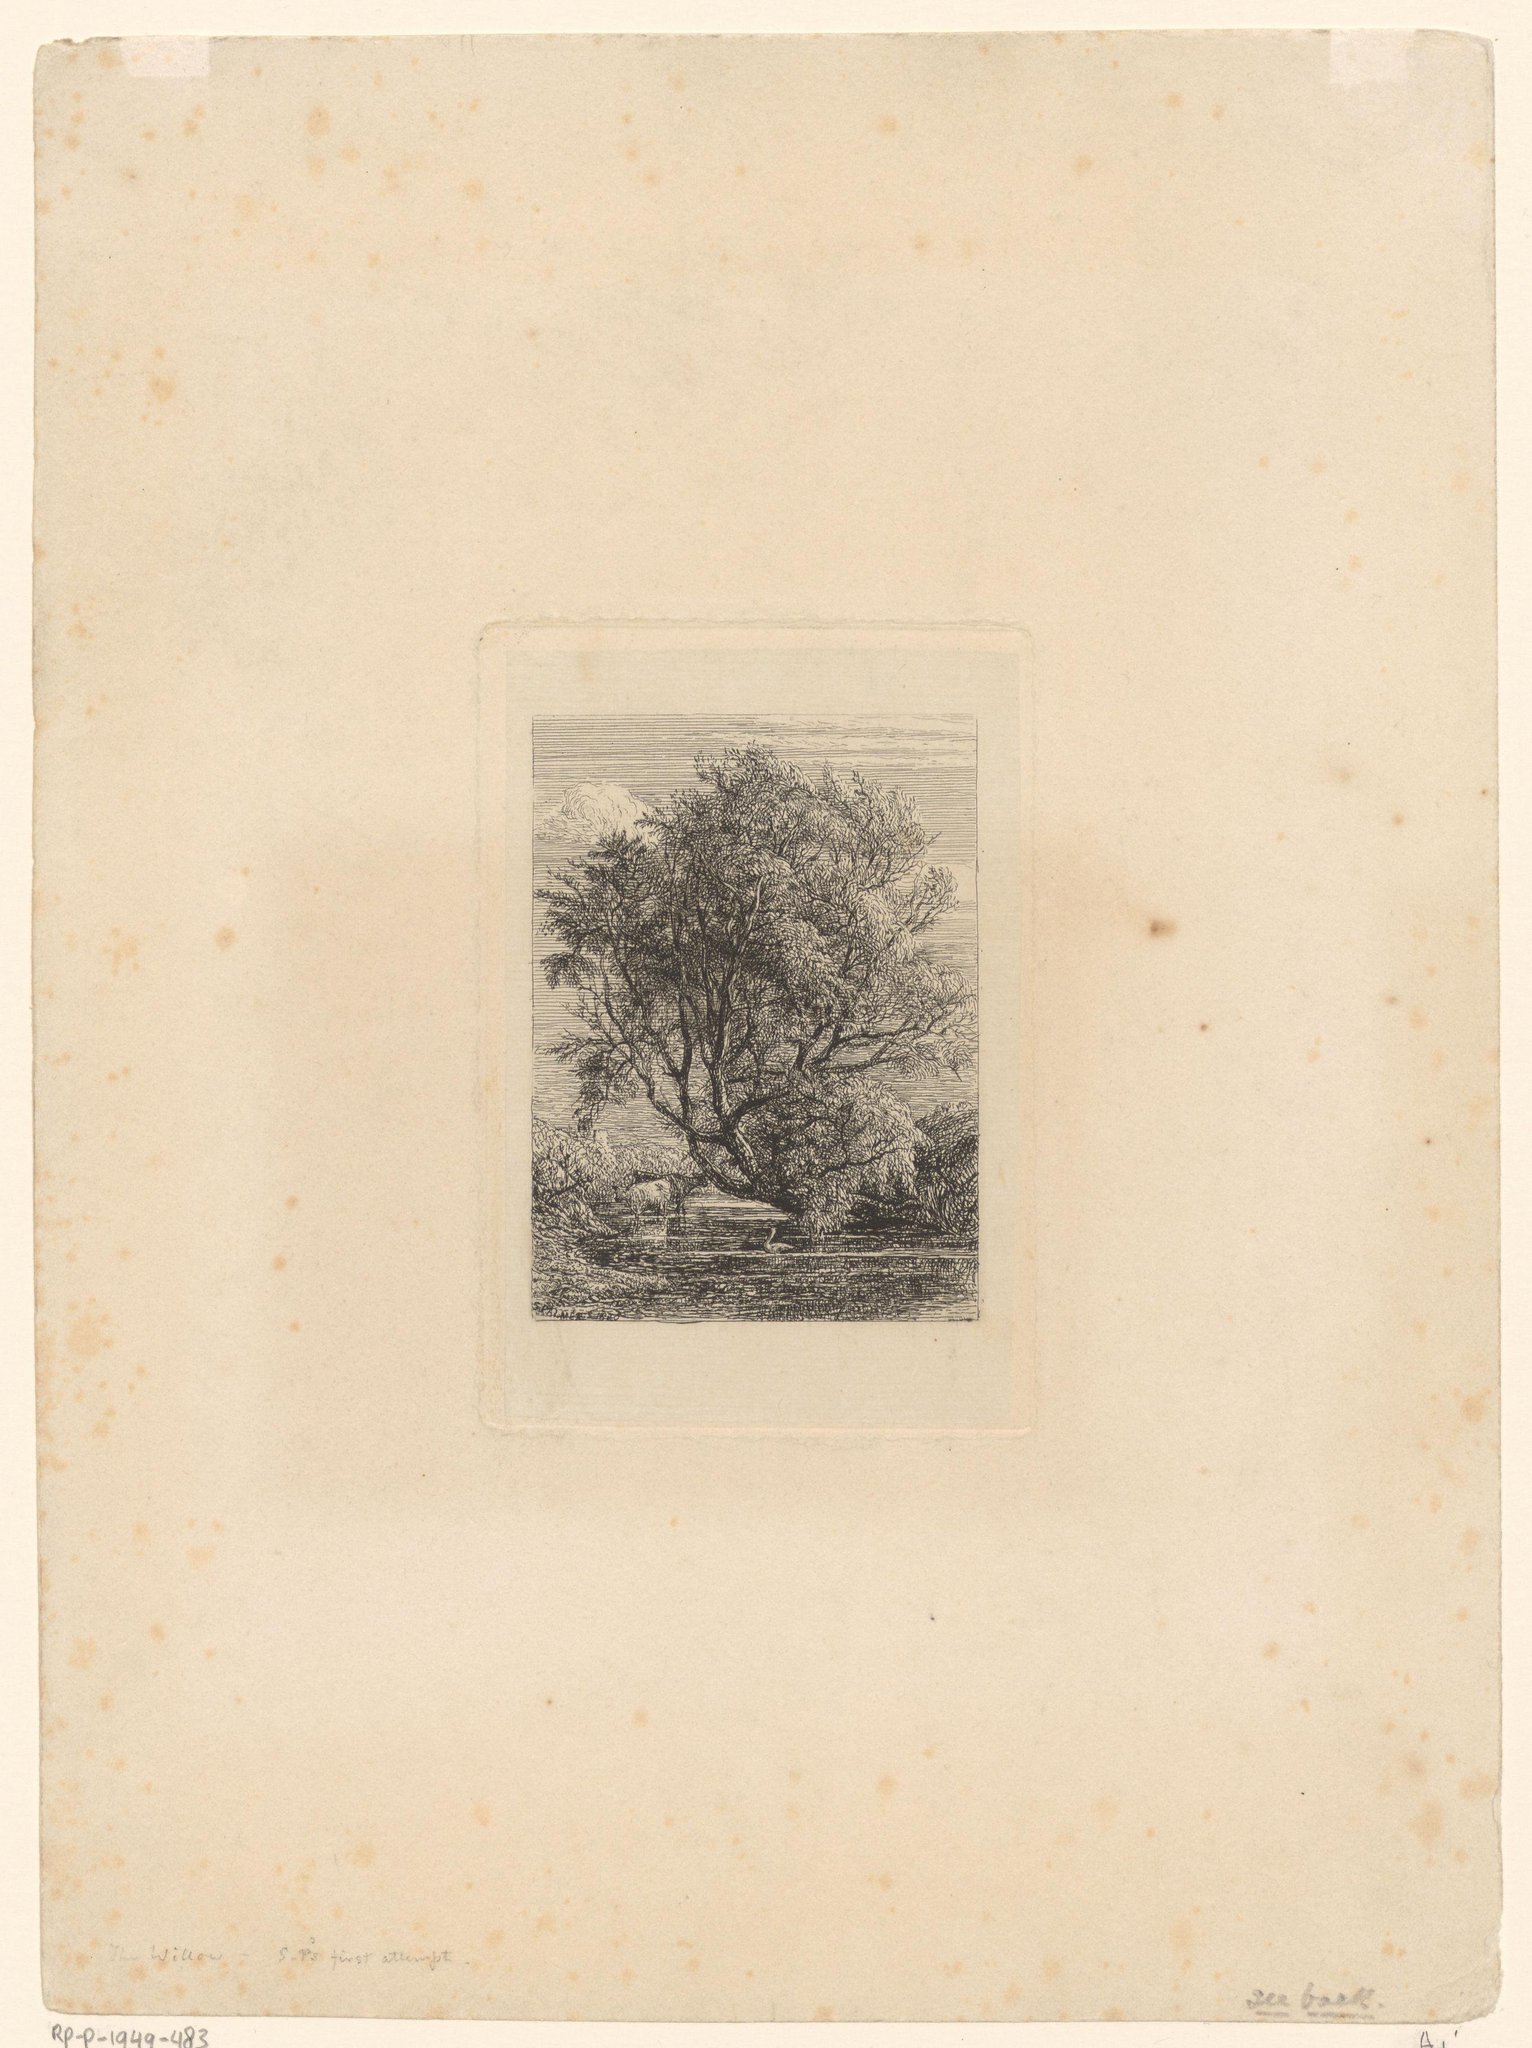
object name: print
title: The Willow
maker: samuel palmer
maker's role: draughtsman, painter, print maker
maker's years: 1805-1881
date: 1850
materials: paper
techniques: etching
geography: england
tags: cow, pond, pool, trees: willow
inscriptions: inscription: ‘Proof of this etching by Samuel Palmer, with his inscription stating that it was his first attempt. [...] me by S. P. F.G. Stephens’, inscription: ‘The Willow - S.P's first attempt’, collector's mark: Lugt 2228